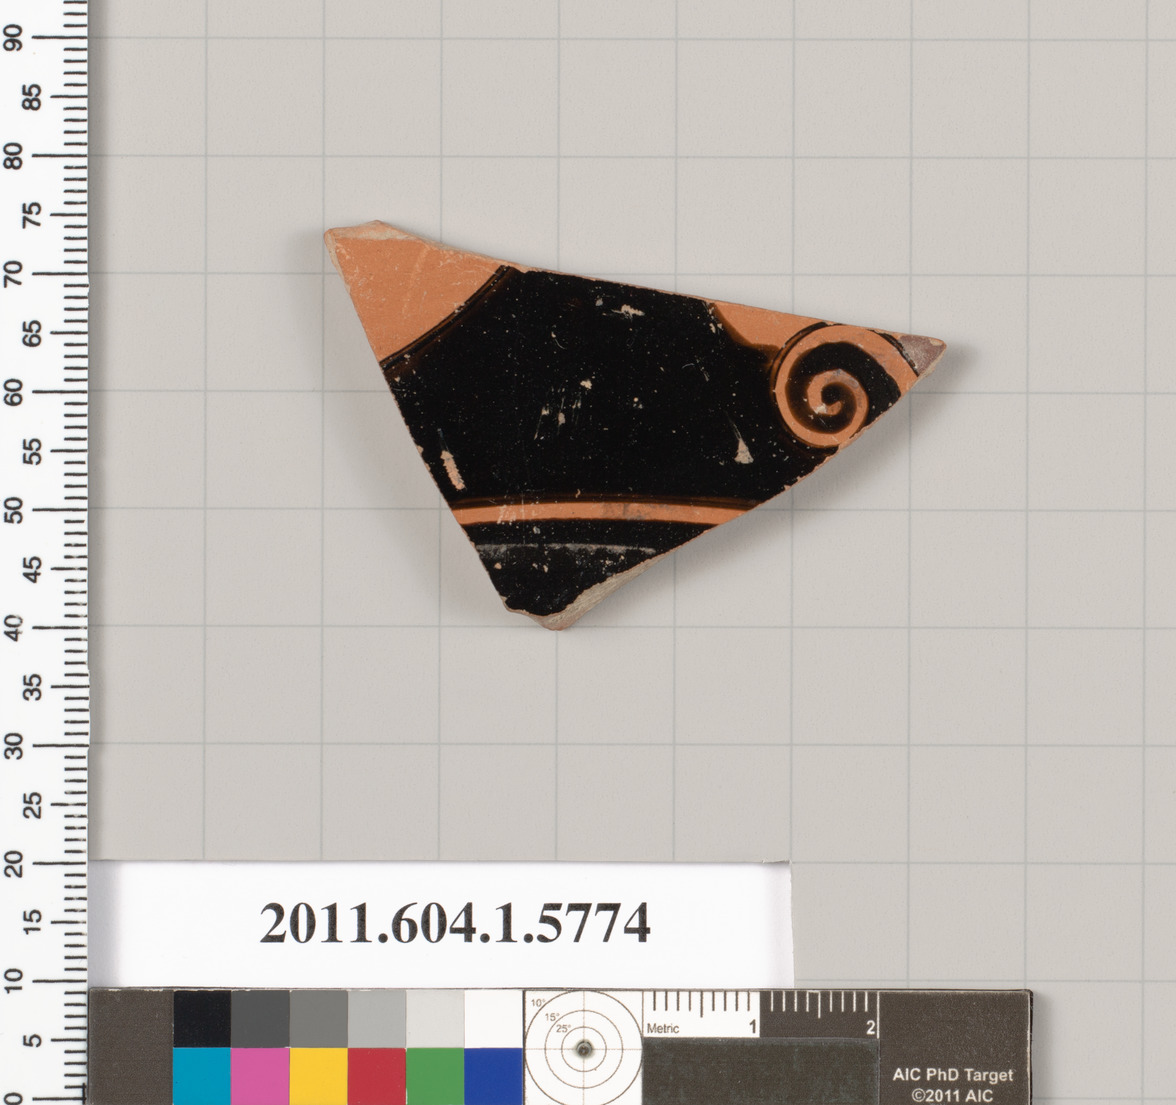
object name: kylix fragment, eye cup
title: Terracotta fragment of a kylix: eye-cup (drinking cup)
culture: greek, attic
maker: oltos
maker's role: artist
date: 520-510 BCE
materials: terracotta